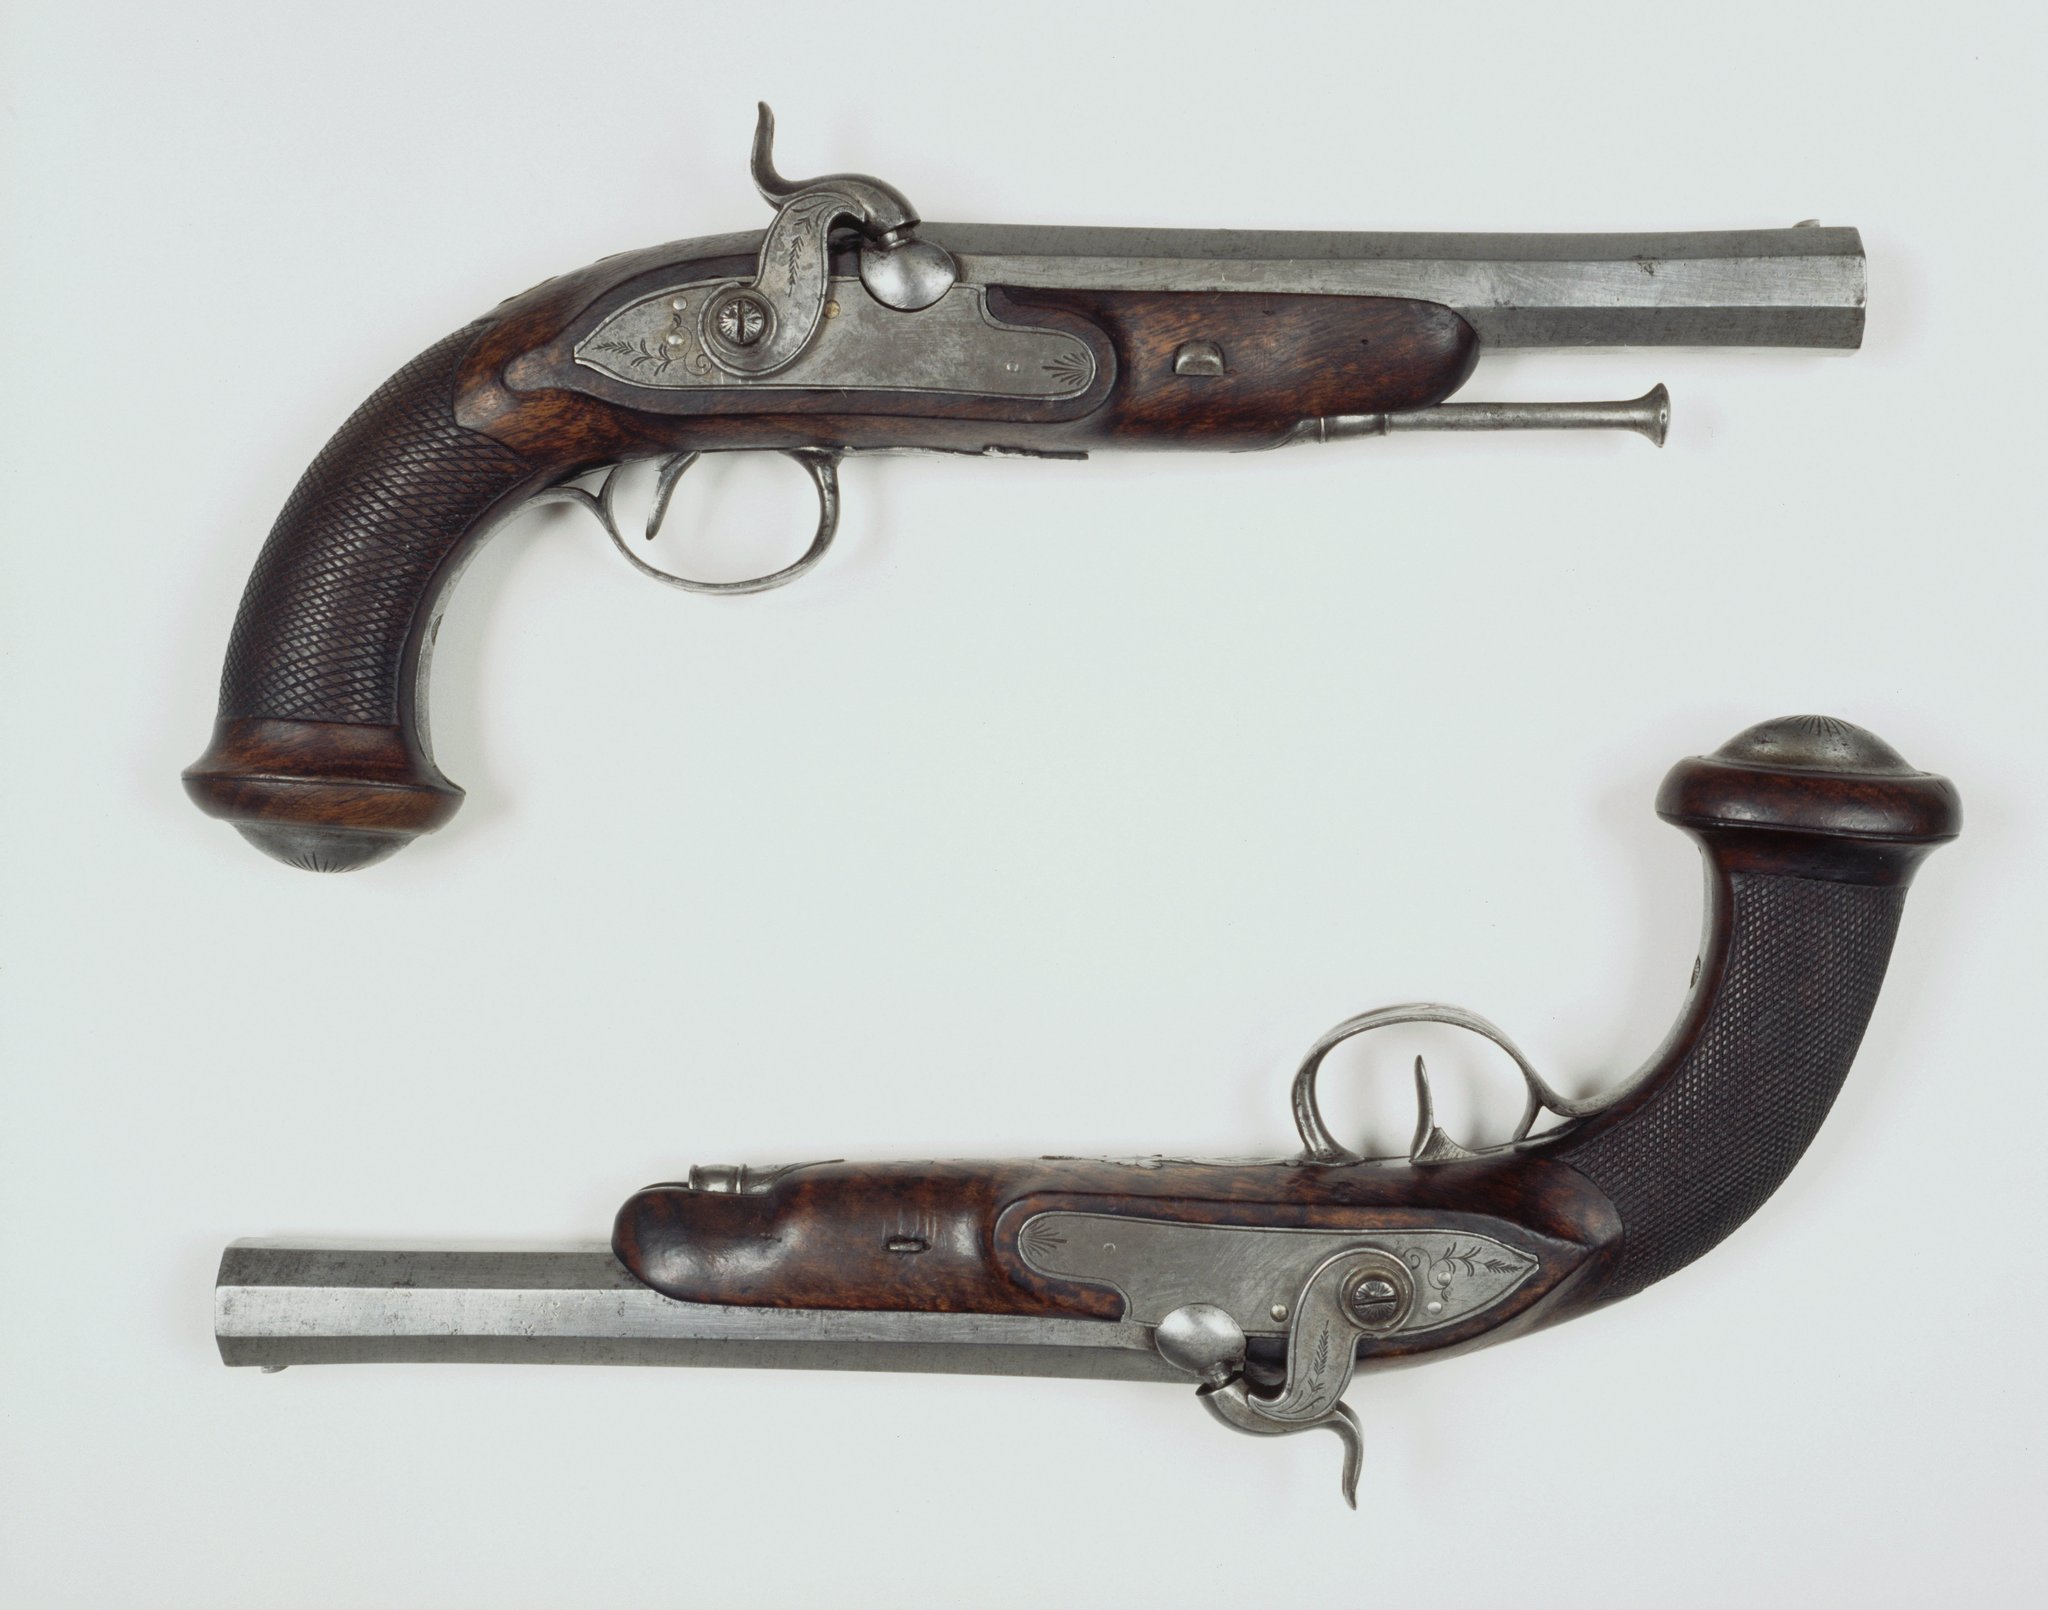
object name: percussion pistol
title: Percussiepistool voor officieren van J.A. Baron de Vos van Steenwijk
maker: Anonymous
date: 1831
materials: alloy, iron, wood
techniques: engraving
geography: liège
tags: germany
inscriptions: mark: ‘E // LG’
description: Percussiepistool, deel van koppel, met achthoekige getrokken loop. De kolf is van notenhout en heeft een ruitgegroefde greep, onder de kolf een ijzeren kolfplaat met een ingekerfde stermotief. De loop ligt in een halve lade van notenhout. Het ijzeren slot is plat en heeft aan weerzijden gegraveerde bloemmotieven. De haan is eveneens gegraveerd. Aan het uiteinde van de gordelhaak een gegroefde inkeping voor de duim. De trekkerbeugel is van ijzer en heeft over de gehele lengte bloemversieringen. Onder de lade een ijzeren laadstok. Op de loop het Luikse keurmerk E.L.G.